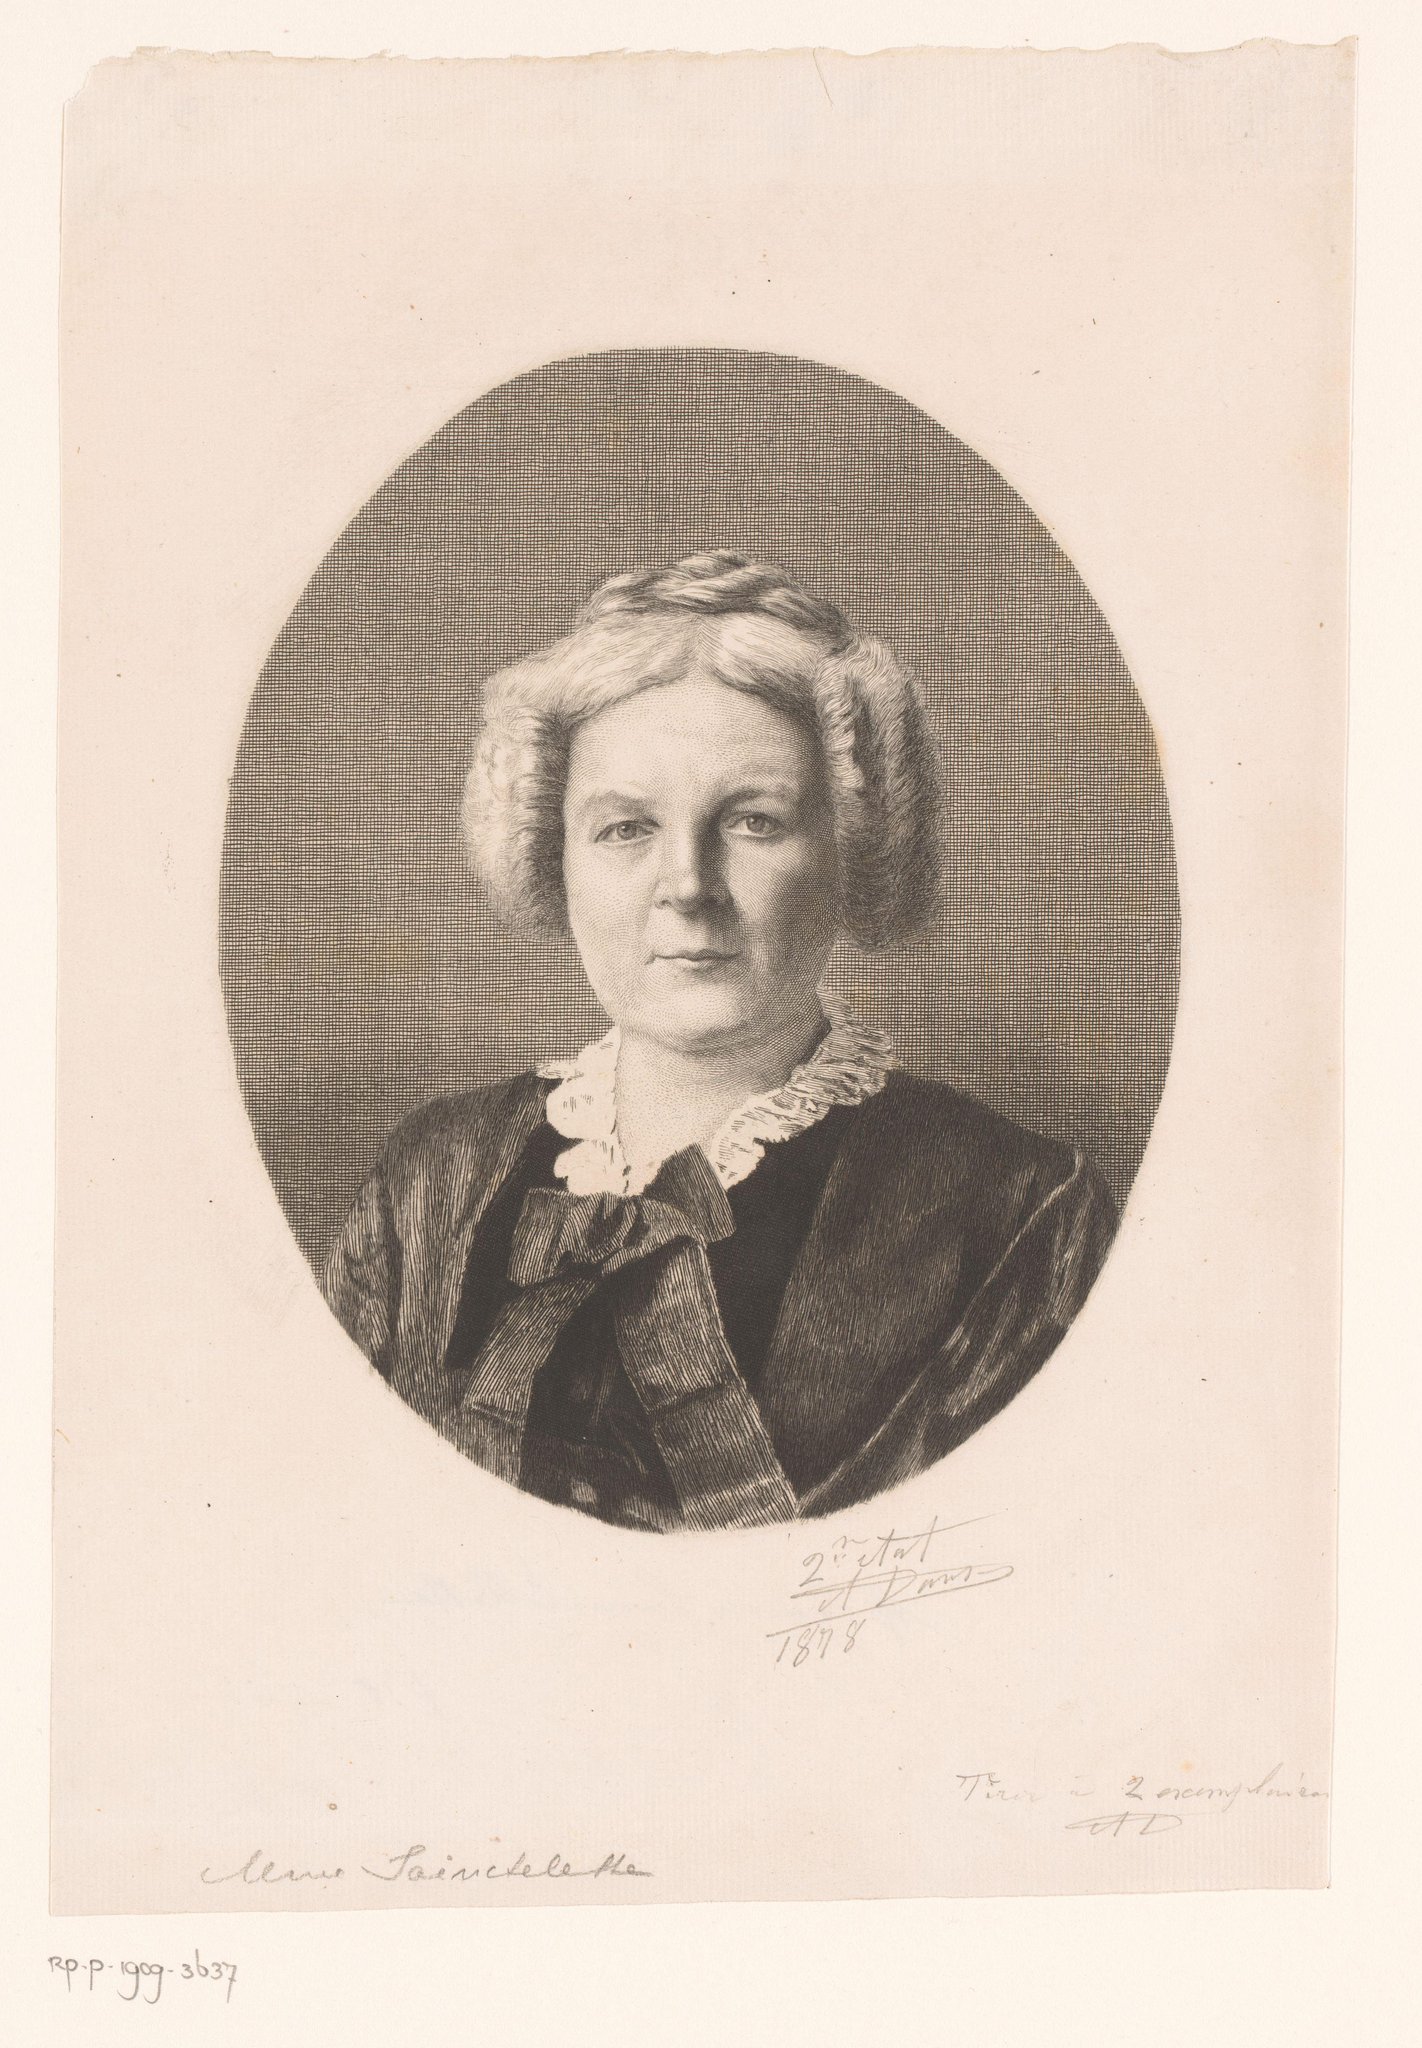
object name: print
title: Portret van een onbekende dame, mevrouw Sainctelette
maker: auguste danse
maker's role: print maker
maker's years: 1829-1929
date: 1878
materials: paper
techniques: drypoint, etching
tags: anonymous historical person portrayed alone - bb - woman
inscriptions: annotation: ‘Tirer a 2 exemplaires AD’, collector's mark: Lugt 2228, annotation: ‘2me état’, annotation: ‘Mme Sainctelette’